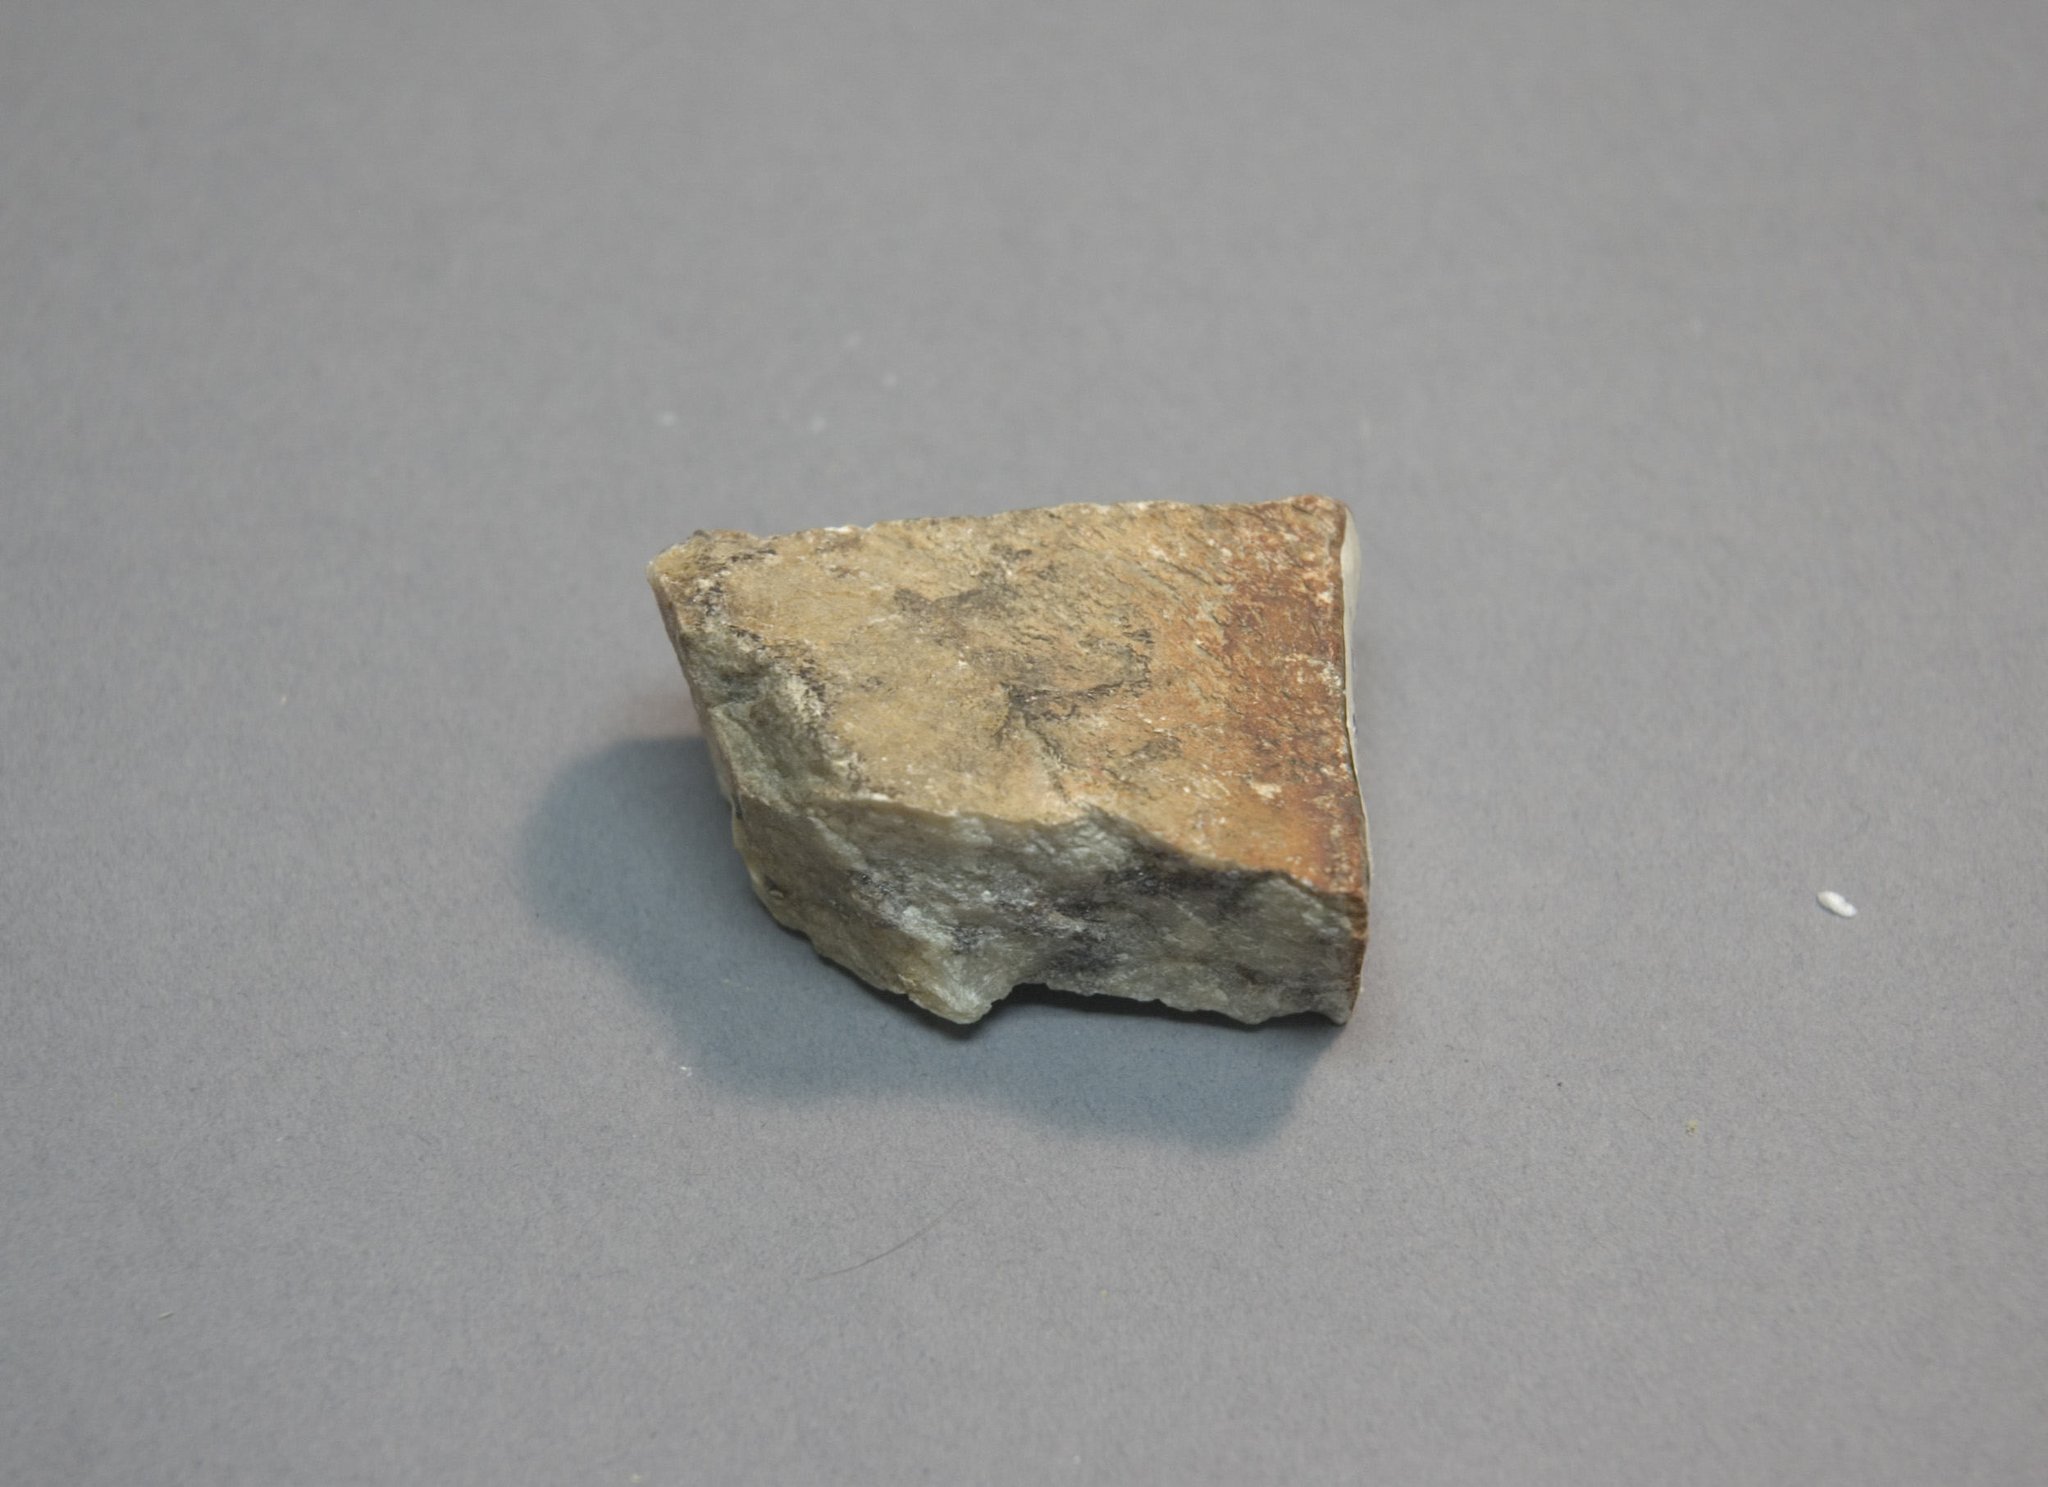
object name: jade carving material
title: Sample of Fibrolite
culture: chinese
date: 1901-2000